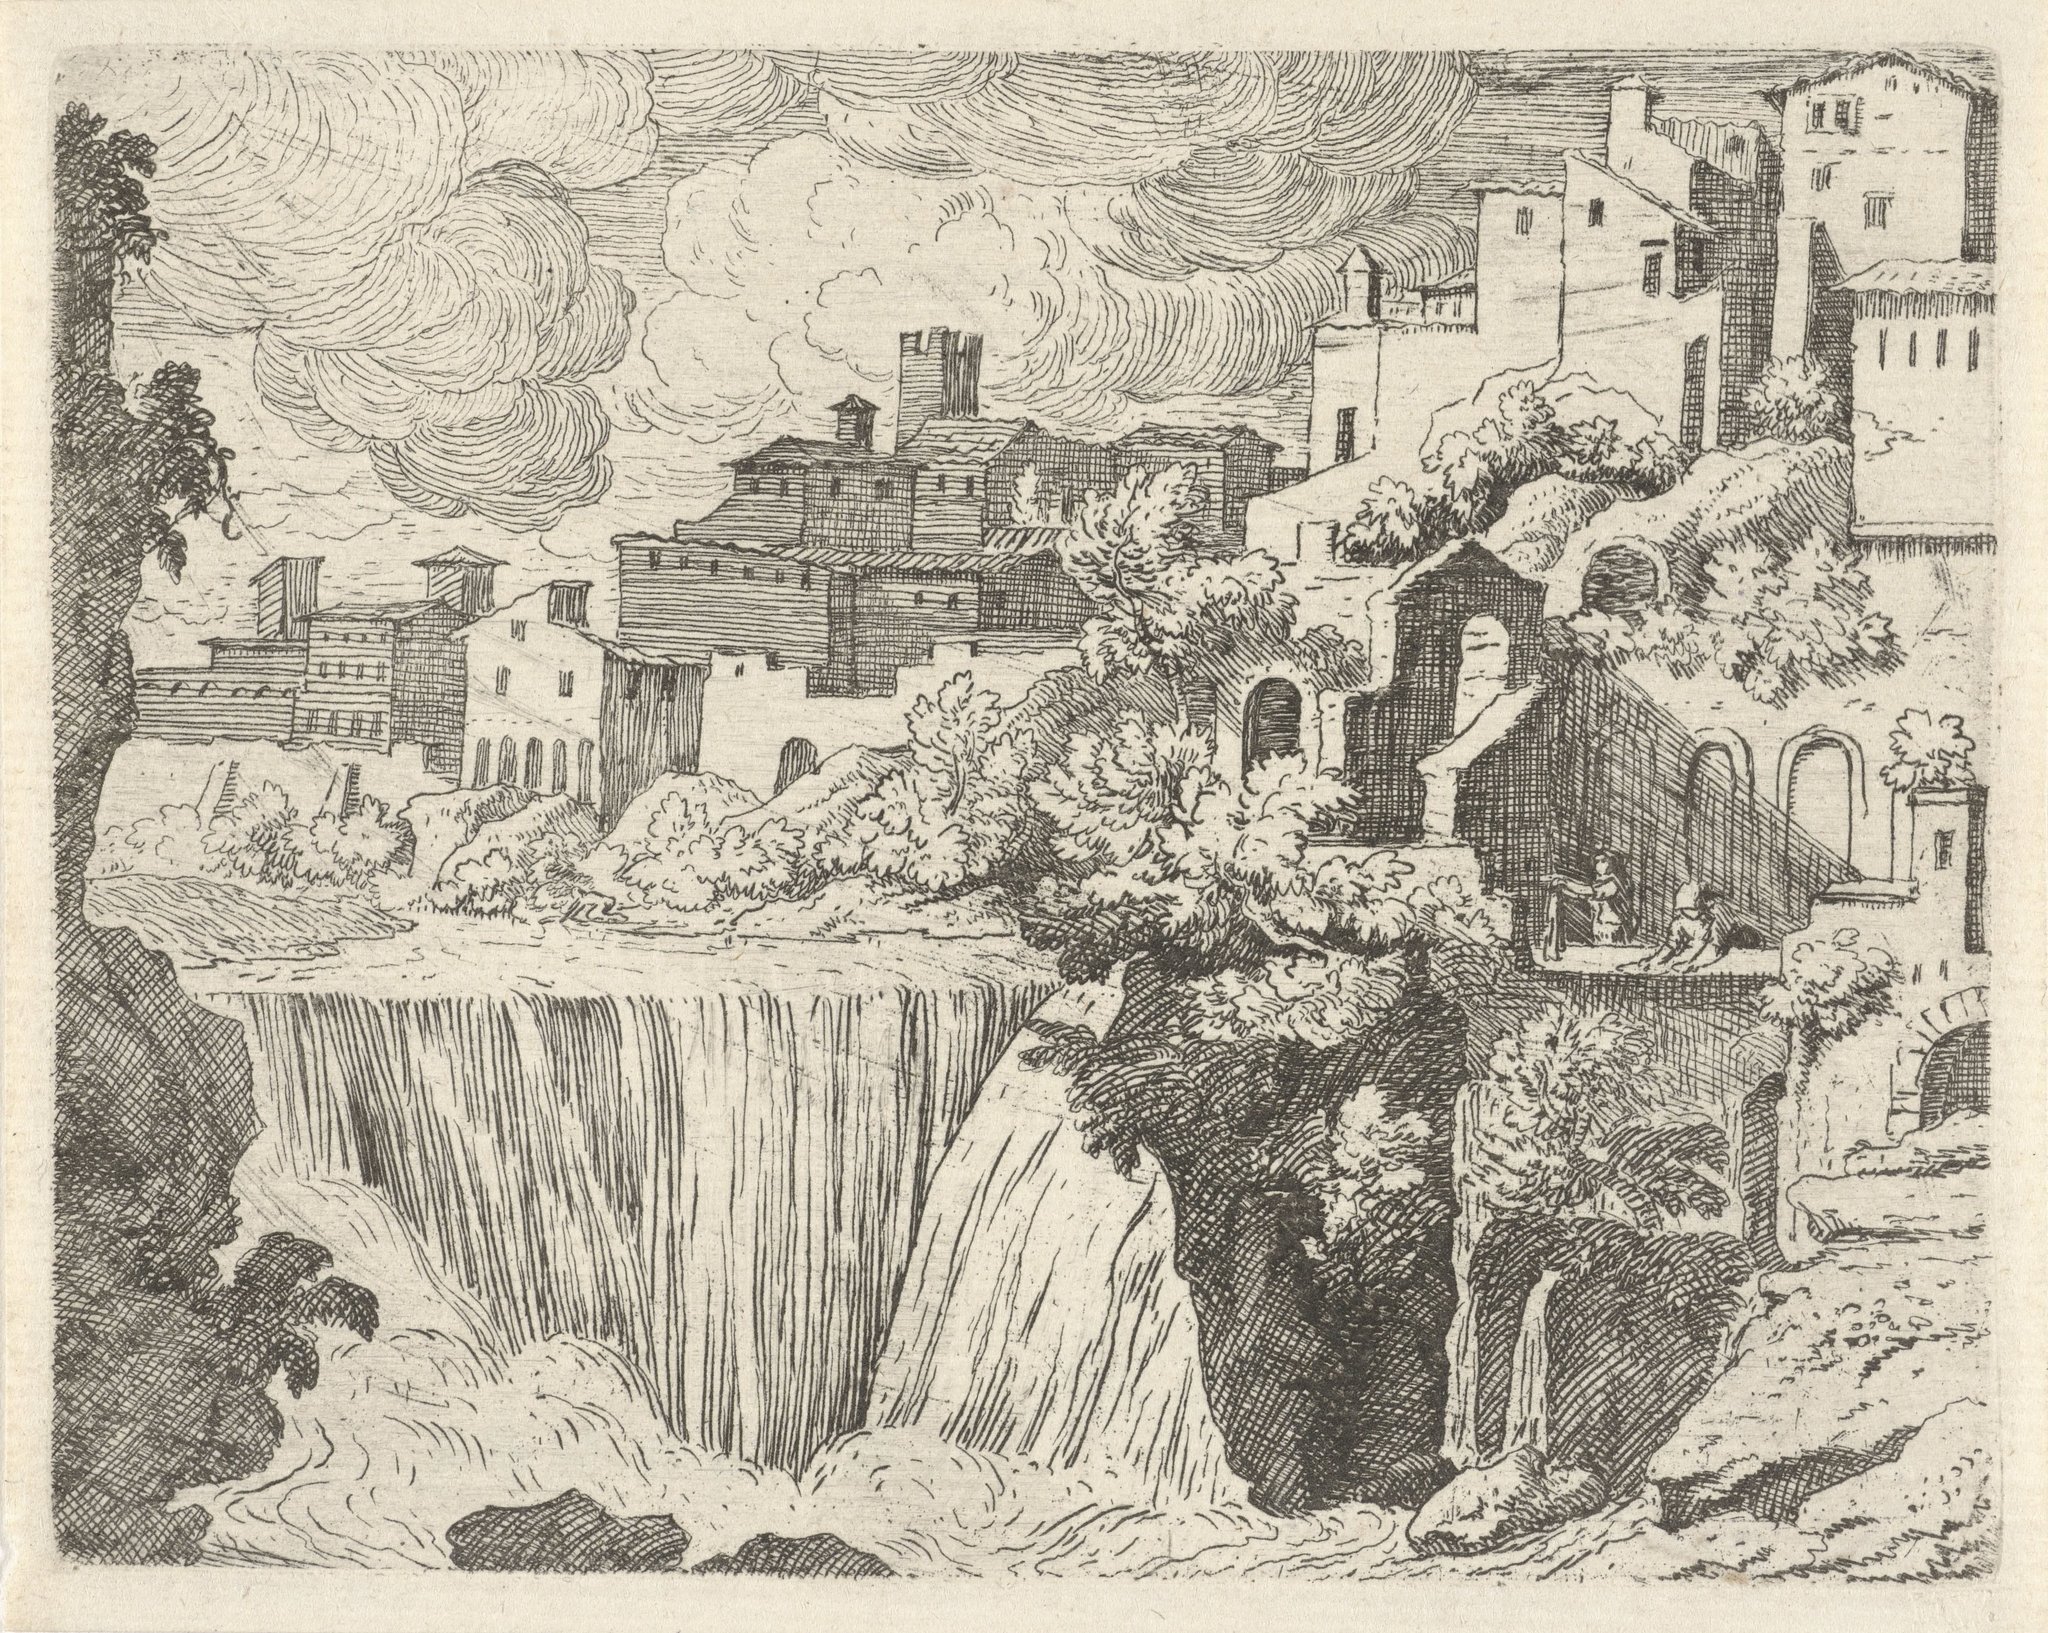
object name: print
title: Italiaanse landschappen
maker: govert van der leeuw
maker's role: print maker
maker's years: 1645-1688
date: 1655-1688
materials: paper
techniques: etching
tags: city-view, and landscape with man-made constructions, waterfall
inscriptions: collector's mark: Lugt 240, collector's mark: Lugt 1920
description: Gezicht op een stad aan een rivier in een heuvelachtig landschap. Op de voorgrond stroomt een waterval. De prent maakt deel uit van een negendelige serie prenten met voorstellingen van diverse dieren.